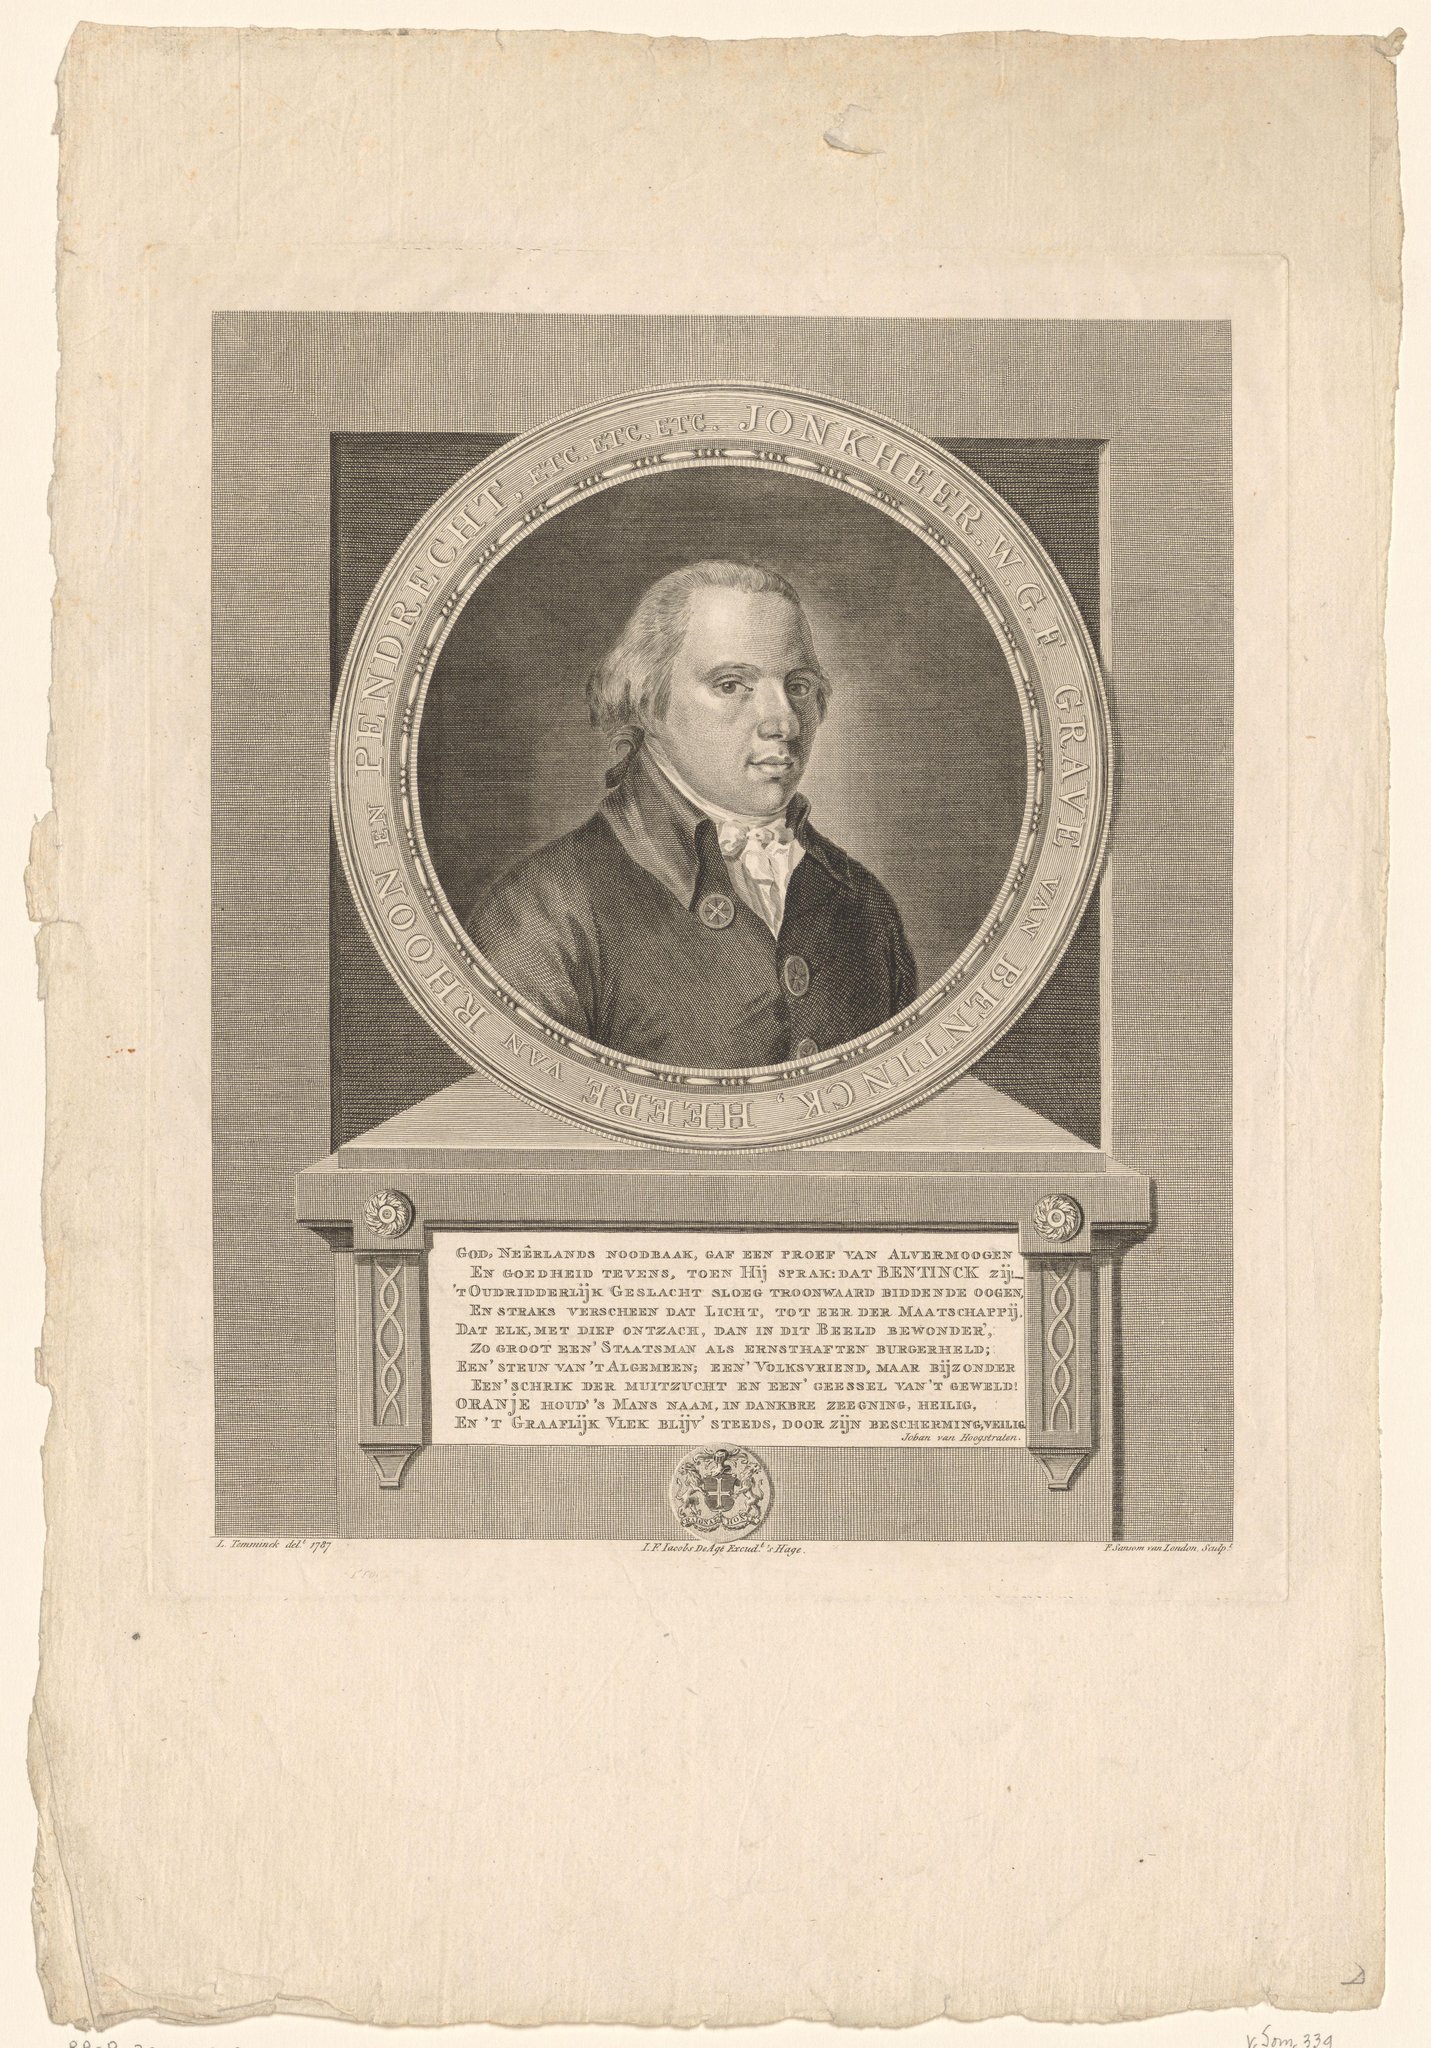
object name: print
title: Portret van Willem Gustaef Frederik Bentinck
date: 1787-1788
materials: paper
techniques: engraving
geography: the hague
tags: historical persons, armorial bearing, heraldry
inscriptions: inscription: ‘[...] Jacobs [...]’, collector's mark: Lugt 2228